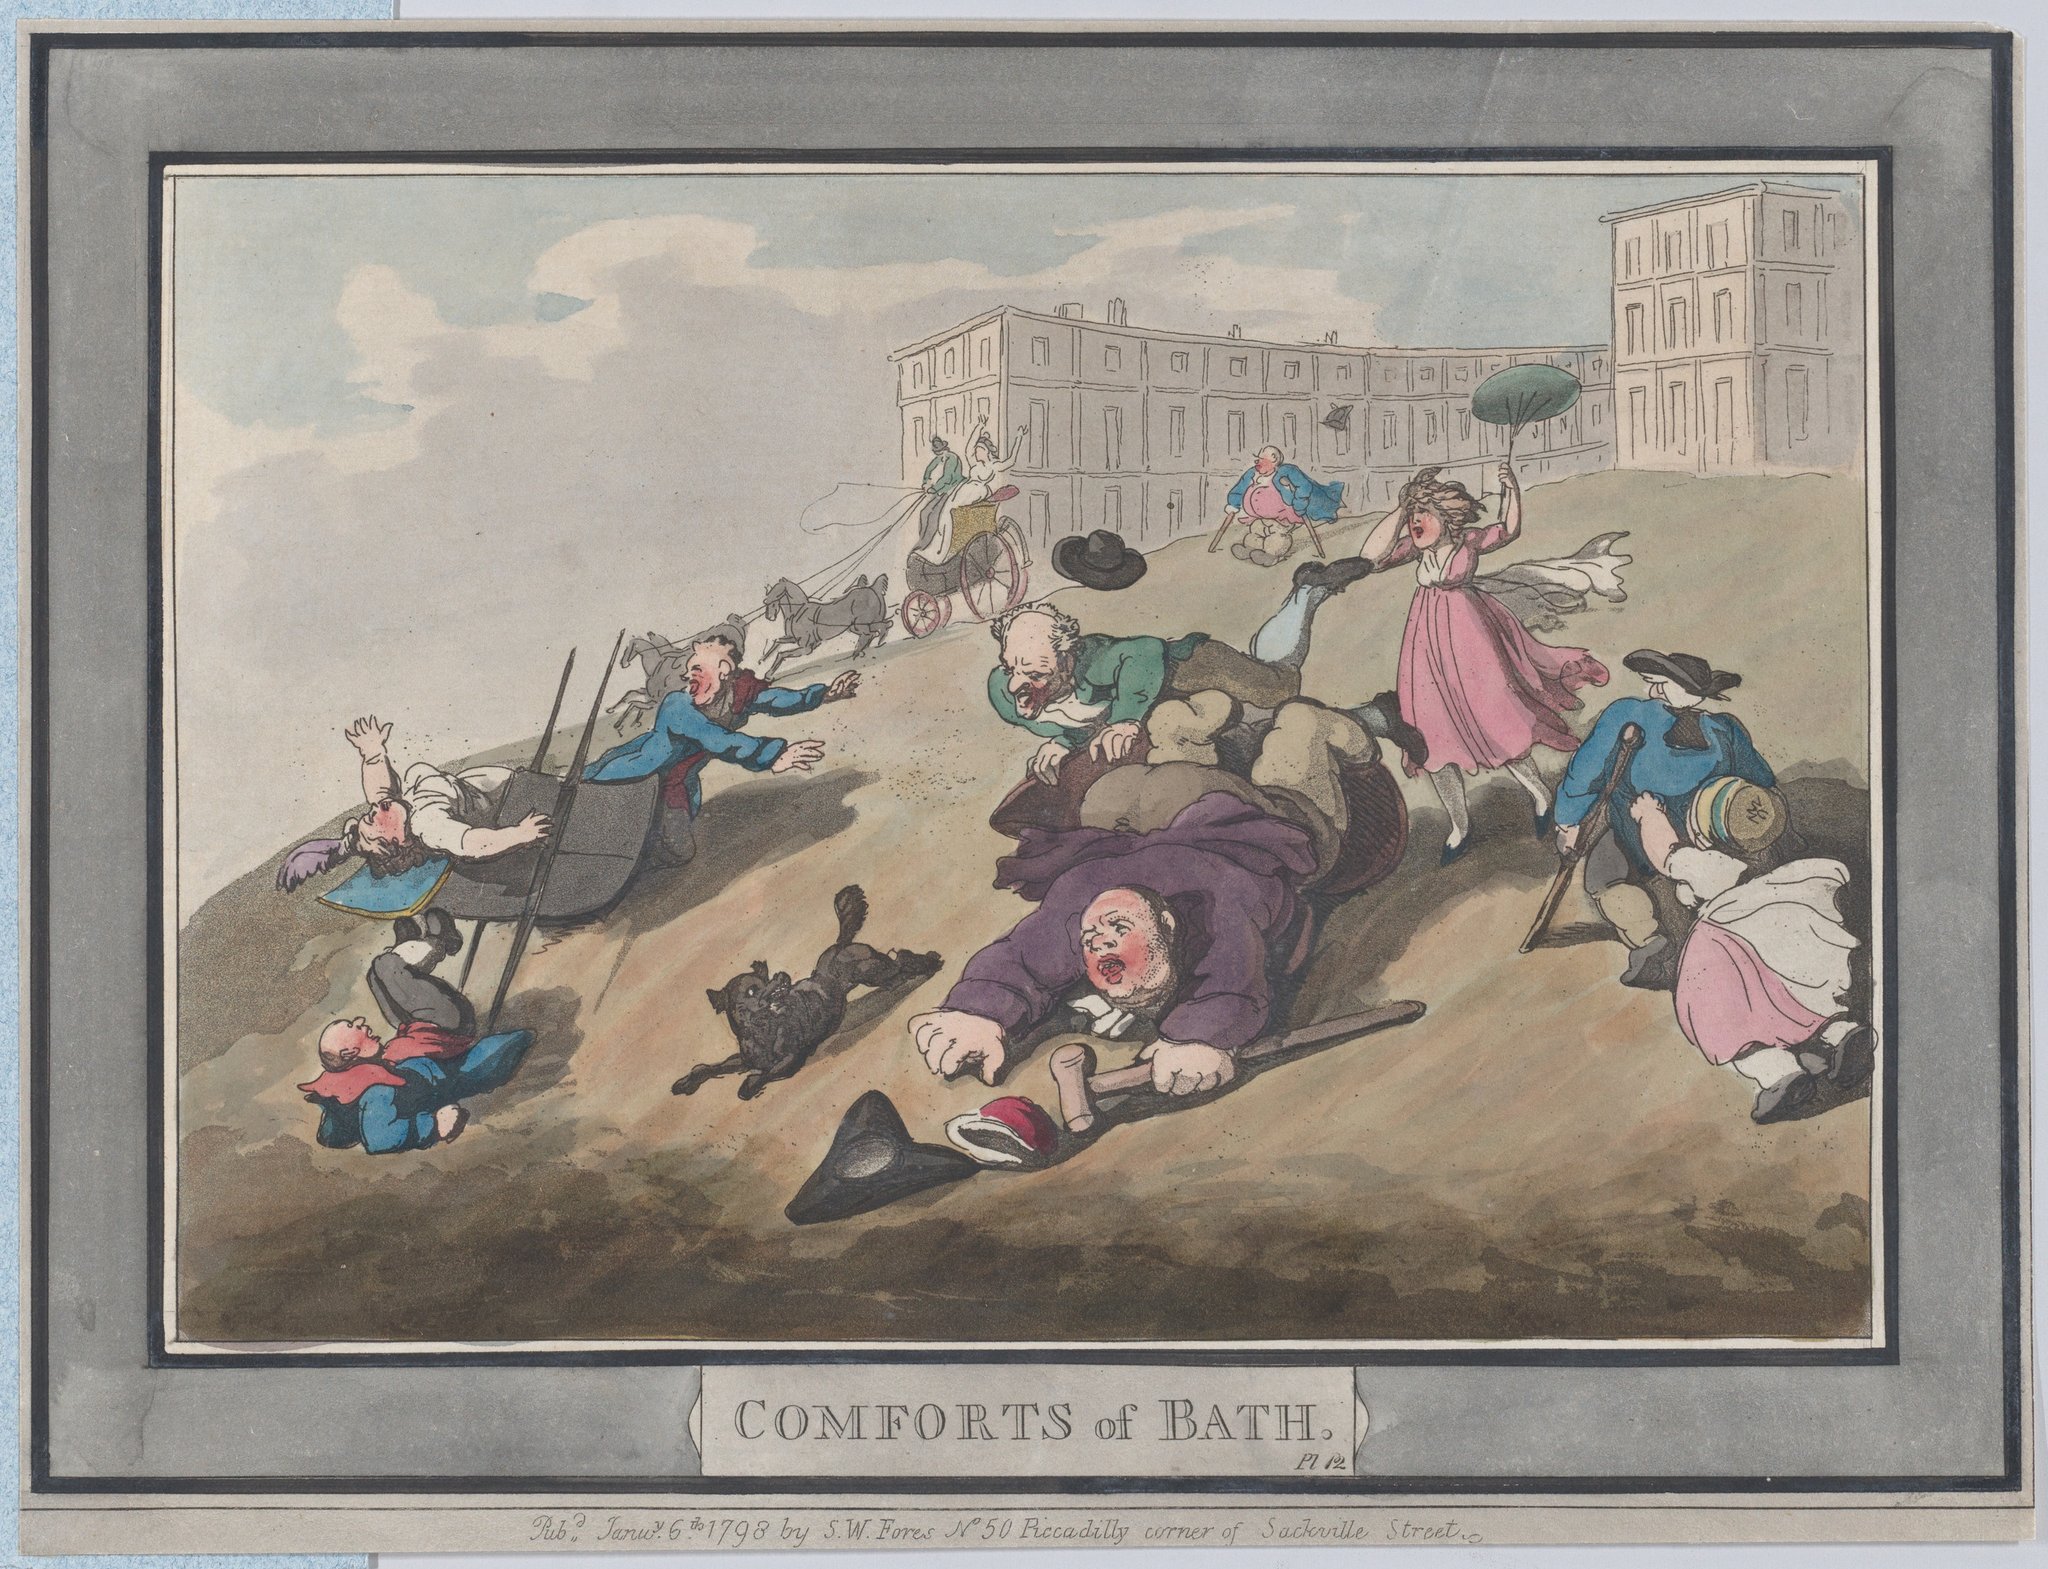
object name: print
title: Comforts of Bath, Plate 12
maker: thomas rowlandson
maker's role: artist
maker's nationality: british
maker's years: 1757-1827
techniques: aquatint, etching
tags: satire,men,women,dogs